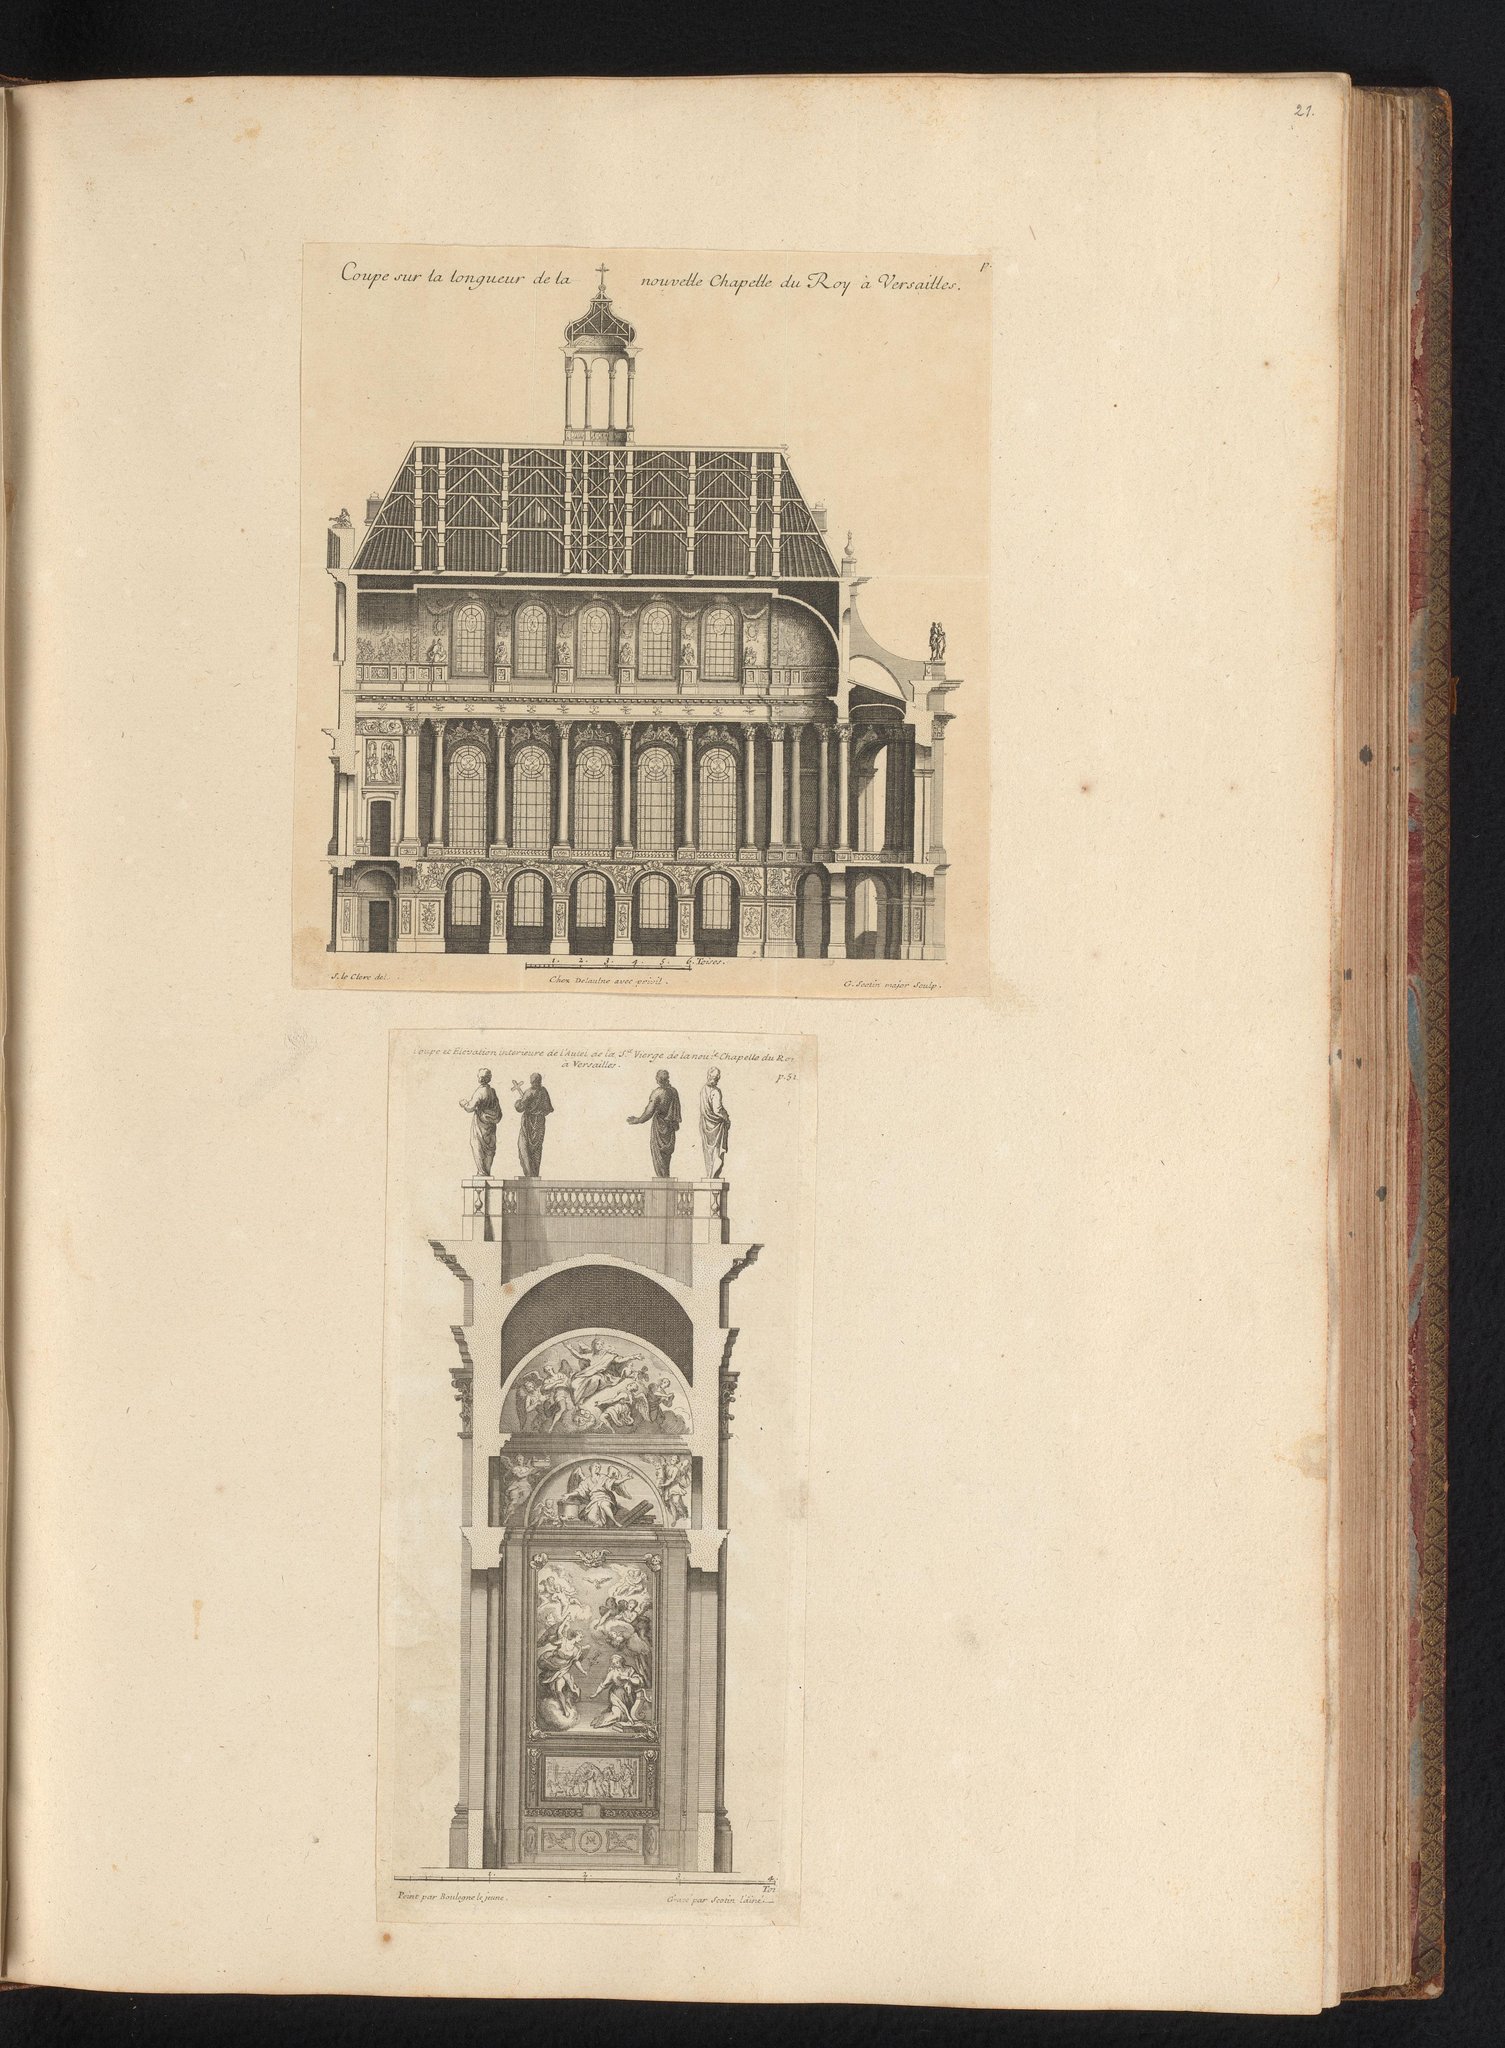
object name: book illustration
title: Twee dwarsdoorsnedes van de kapel van Versailles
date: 1710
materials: paper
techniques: etching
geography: paris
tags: parts of church interior: chapel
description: Prent uit een onbekende uitgave van: Piganiol de la Force, Jean-Aimar. Nouvelle description des chateaux et parcs de Versailles et de Marly (...). Parijs: Étienne-François Savoye.